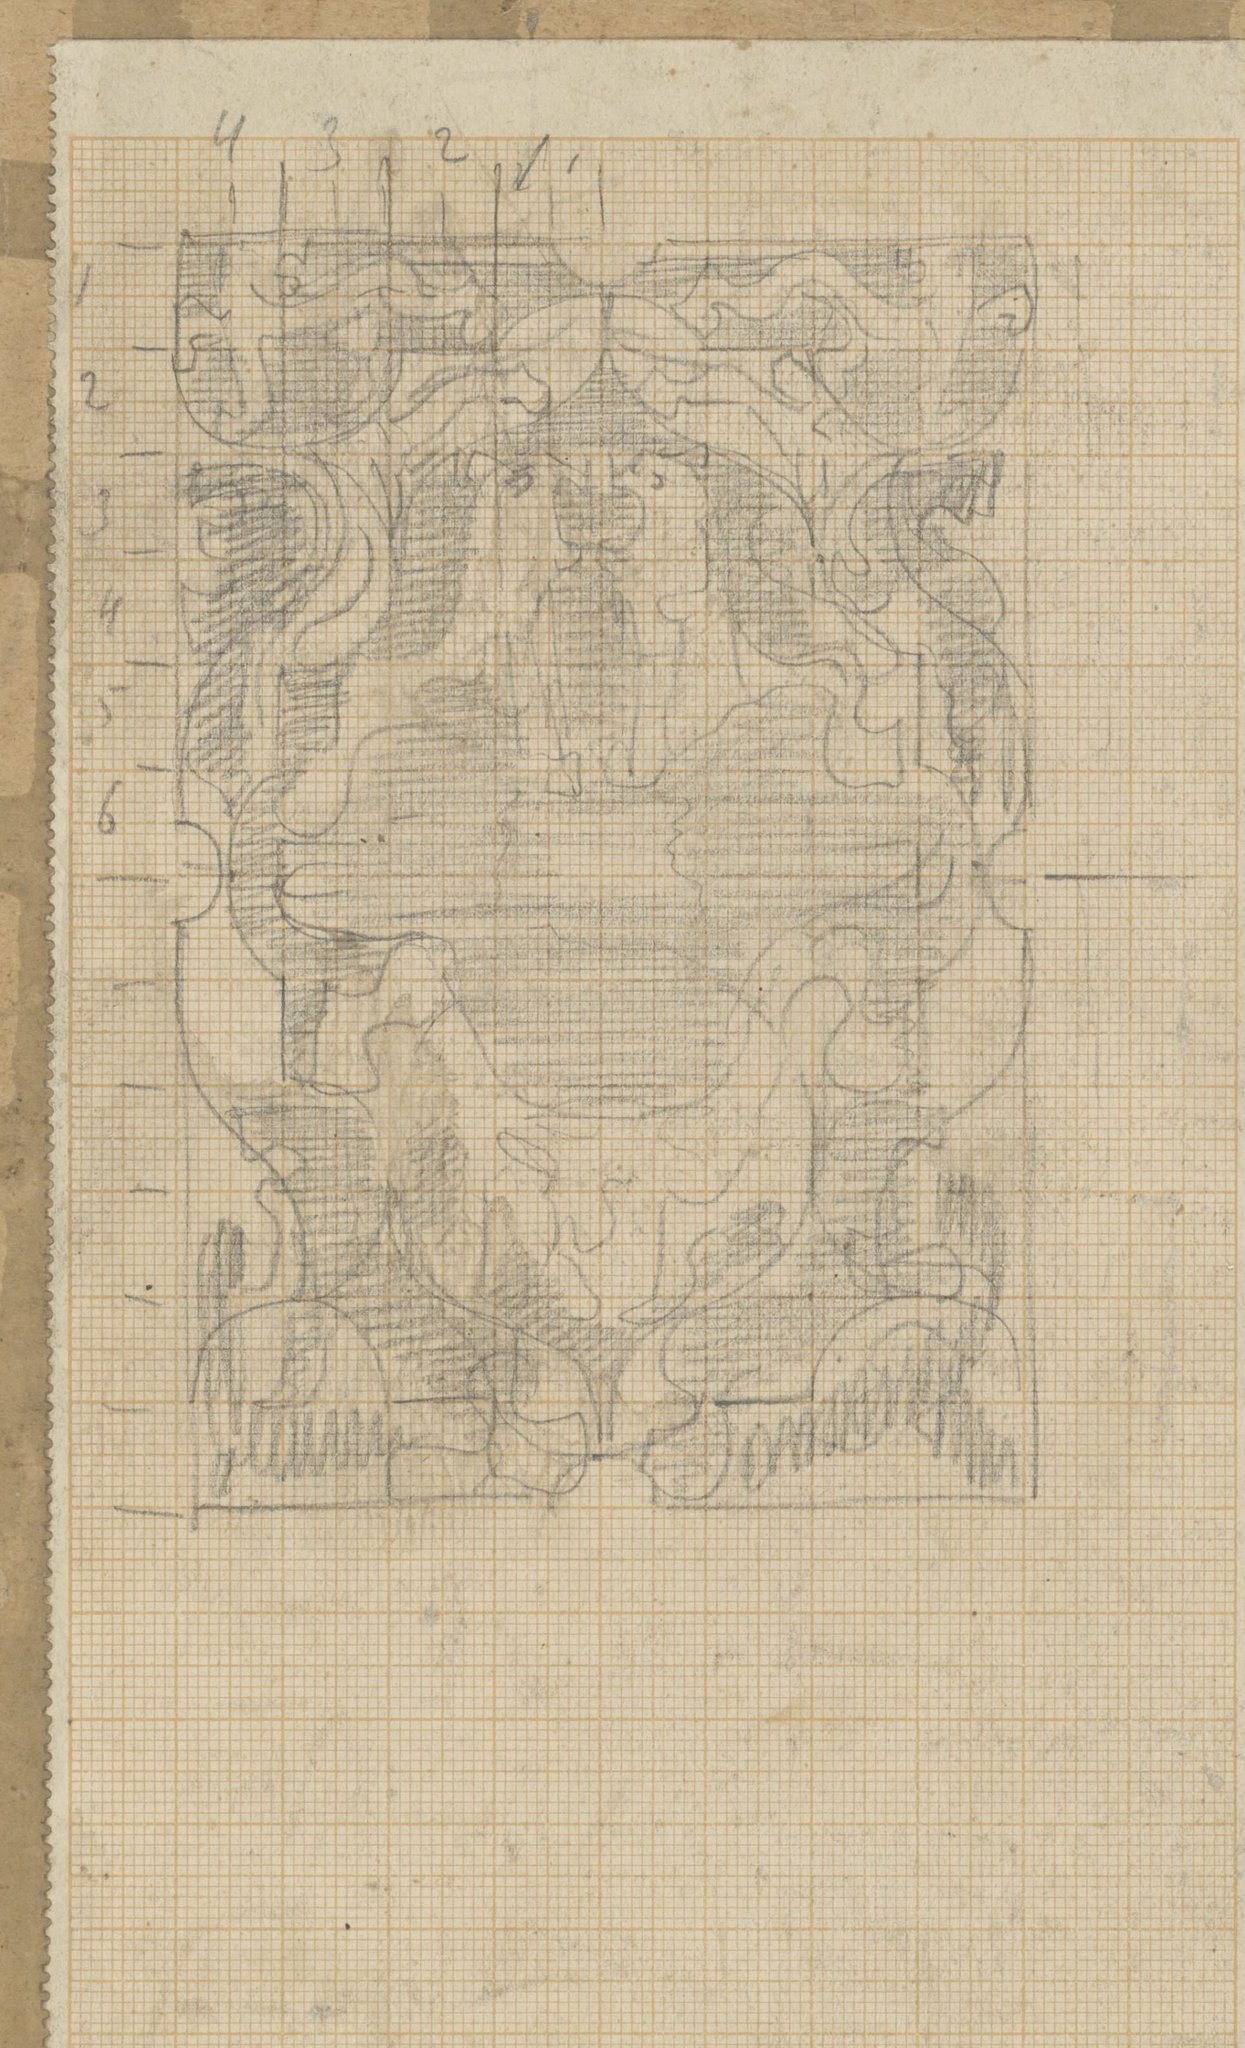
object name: design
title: Decoratief ontwerp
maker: carel adolph lion cachet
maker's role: draughtsman, print maker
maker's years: 1864-1945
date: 1874-1945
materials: pencil